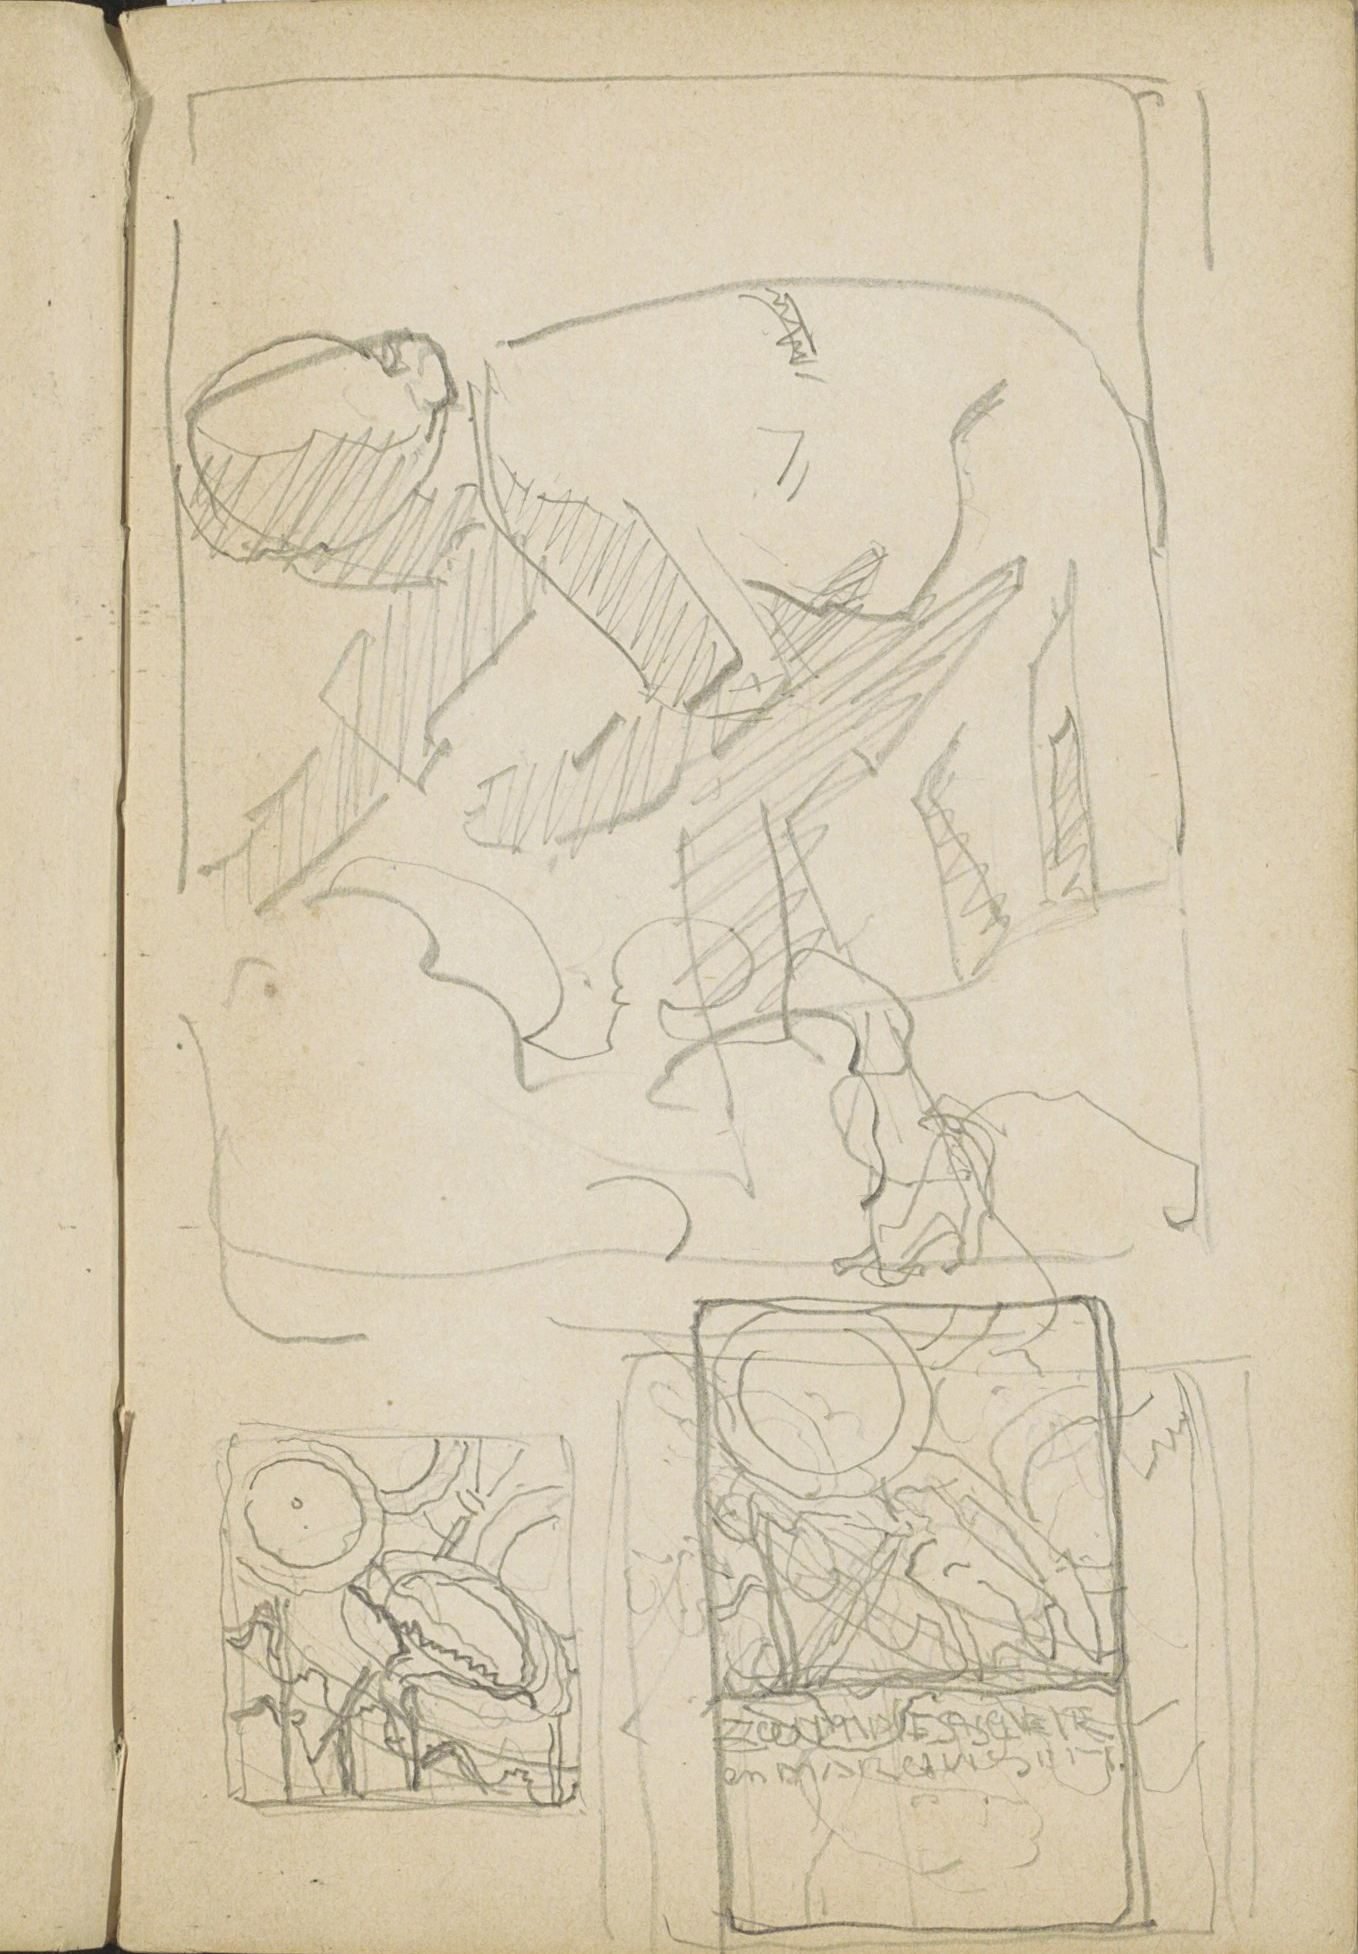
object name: sketchbook leaf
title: Drie composities, waarvan één met een figuur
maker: reijer stolk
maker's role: draughtsman, print maker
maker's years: 1896-1945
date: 1908-1919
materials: paper, pencil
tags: printed matter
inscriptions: annotation: ‘[...] en MARQUIS[...]’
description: Mogelijk ontwerpen voor drukwerk. Blad 2 recto uit een schetsboek met 33 bladen.